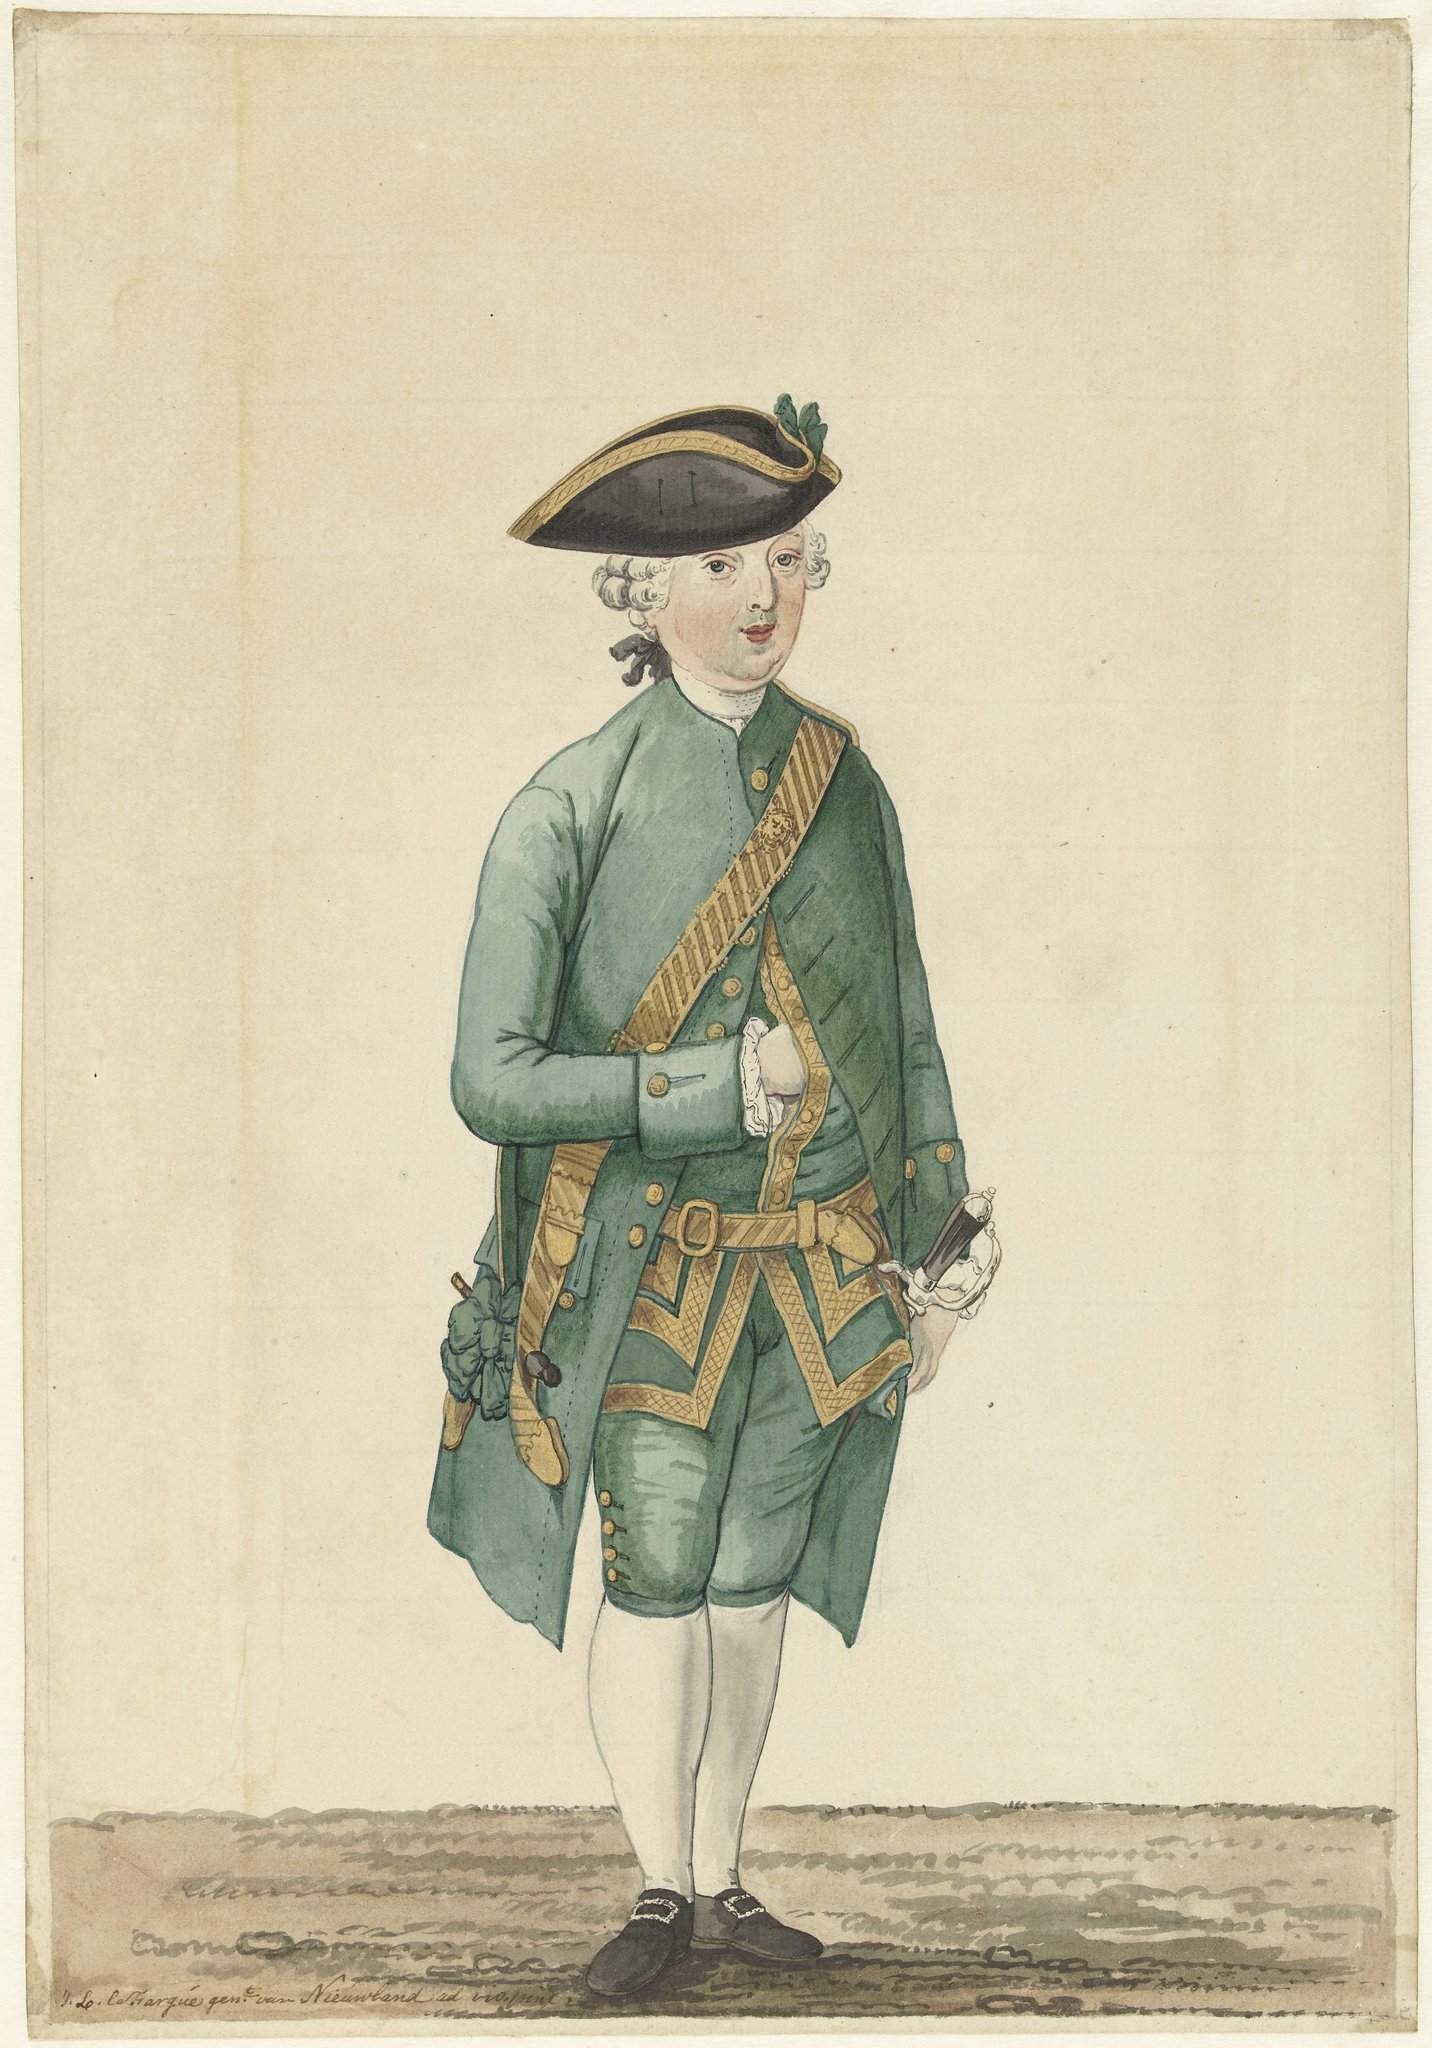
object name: kostuumstudie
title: Costumes van het hof van Willem V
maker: isaac lodewijk la fargue van nieuwland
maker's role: draughtsman, painter, print maker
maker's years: 1726-1805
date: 1766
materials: ink, paper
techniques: brush, pen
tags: the hague, william v (prince of orange)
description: Blad 20 uit serie van 24 tekeningen met leden van de hofhouding van stadhouder Willem V.